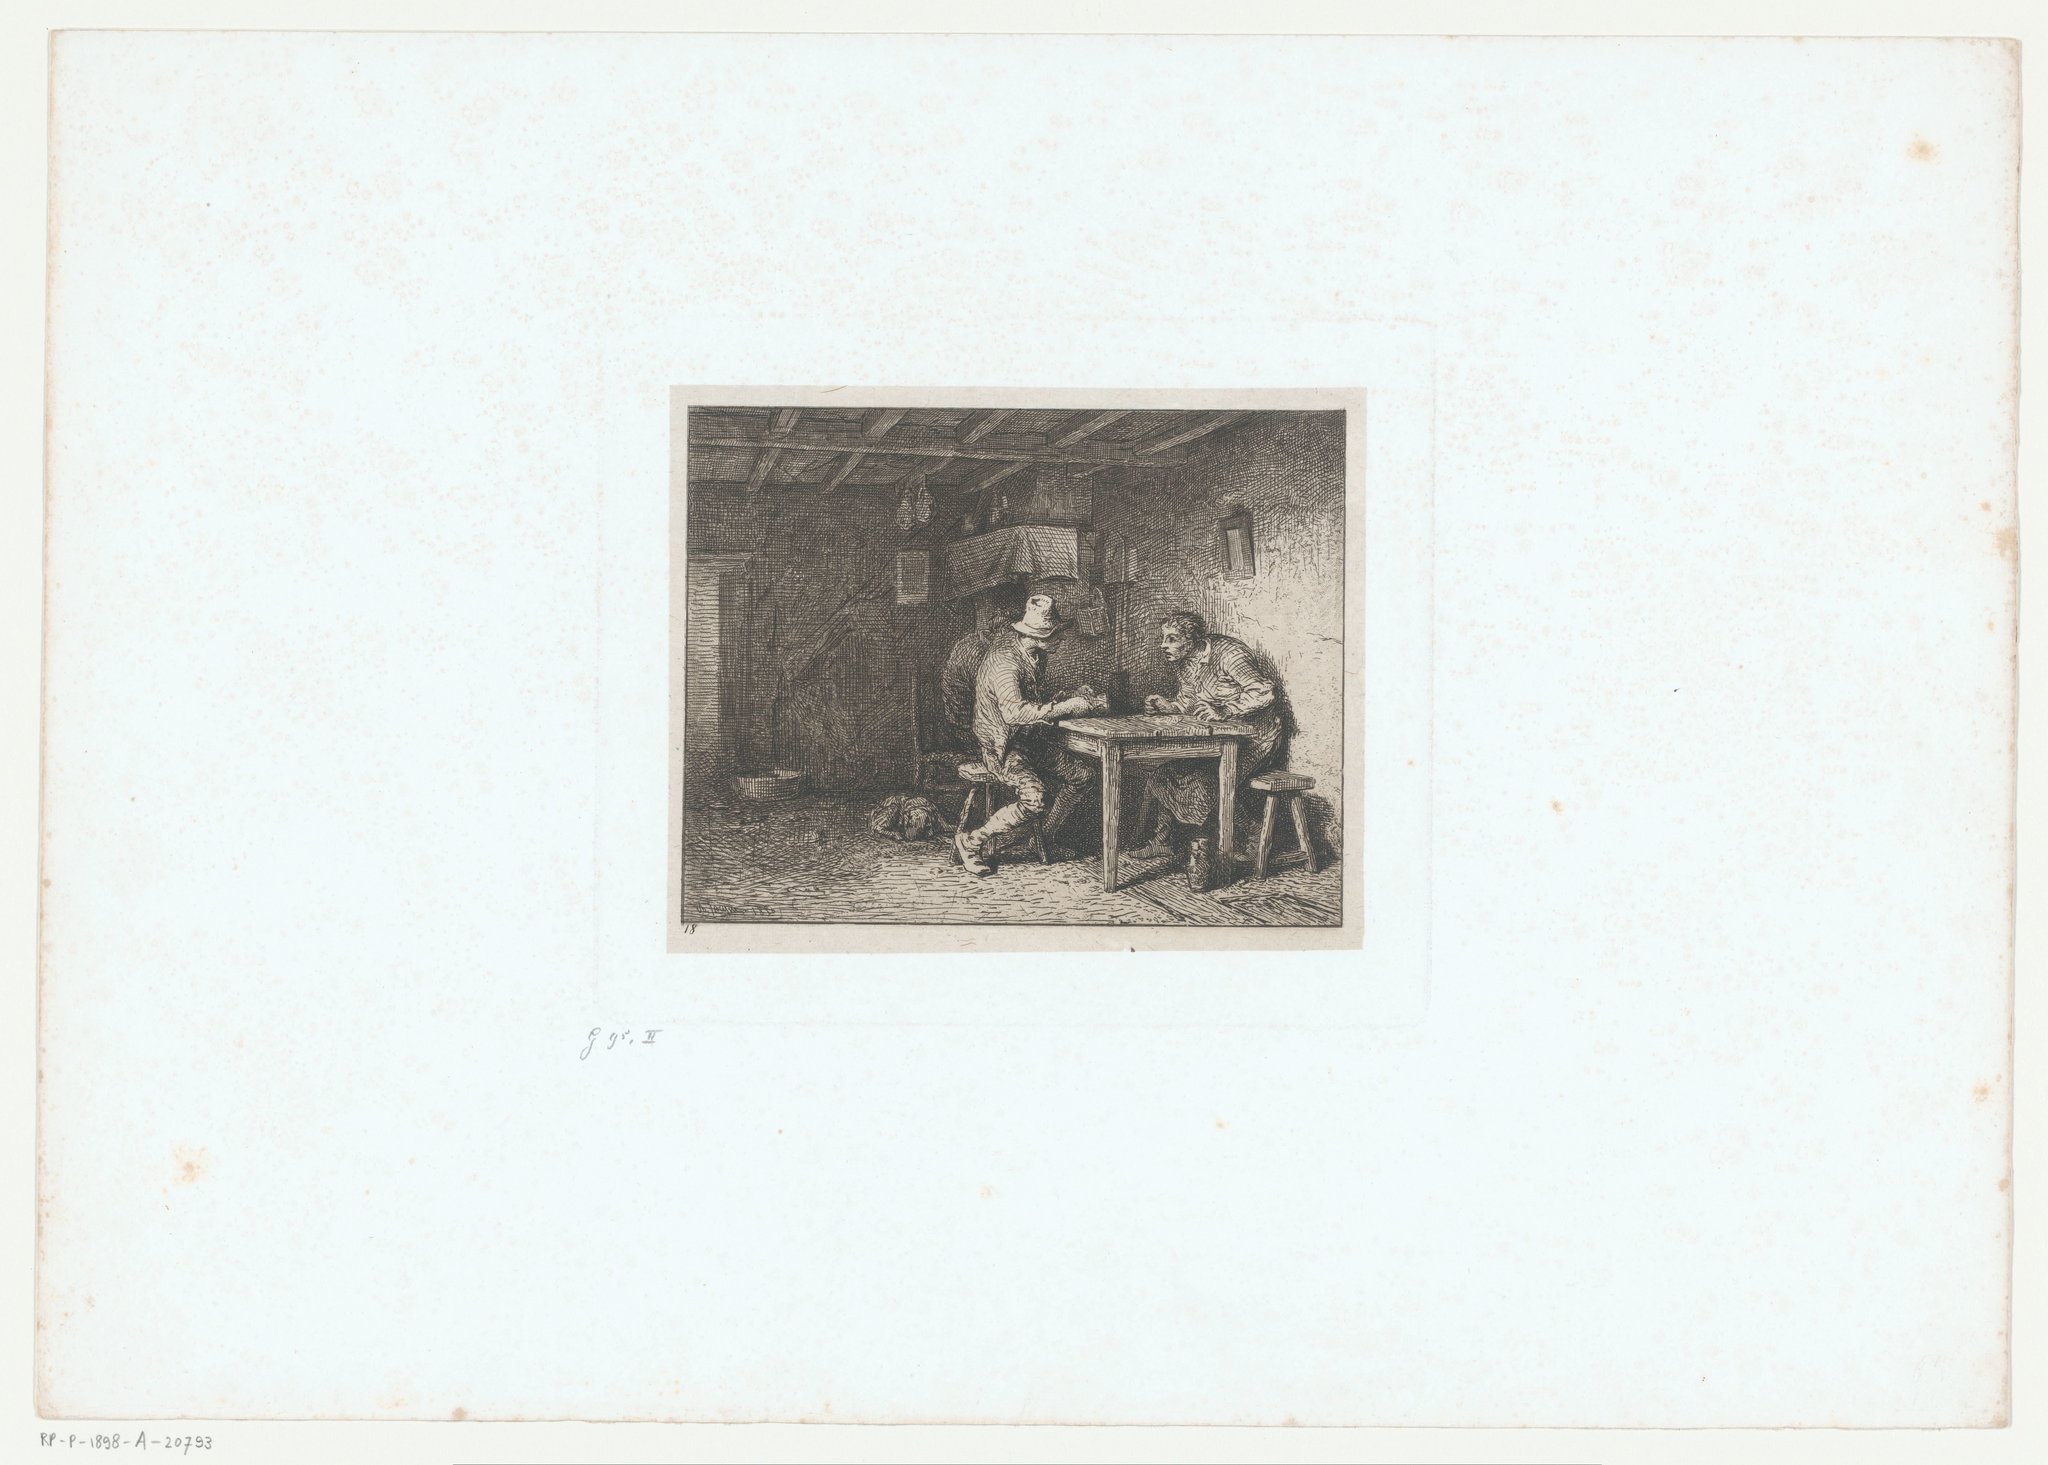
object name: print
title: Interieur met kaartspelers aan een tafel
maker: charles emile jacque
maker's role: draughtsman, painter, print maker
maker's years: 1813-1894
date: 1850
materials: paper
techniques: etching, roulette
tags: card games, interior of the house, playing-cards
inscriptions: collector's mark: Lugt 964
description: Maakt deel uit van een twintigdelige serie met verschillende onderwerpen door Jacque.